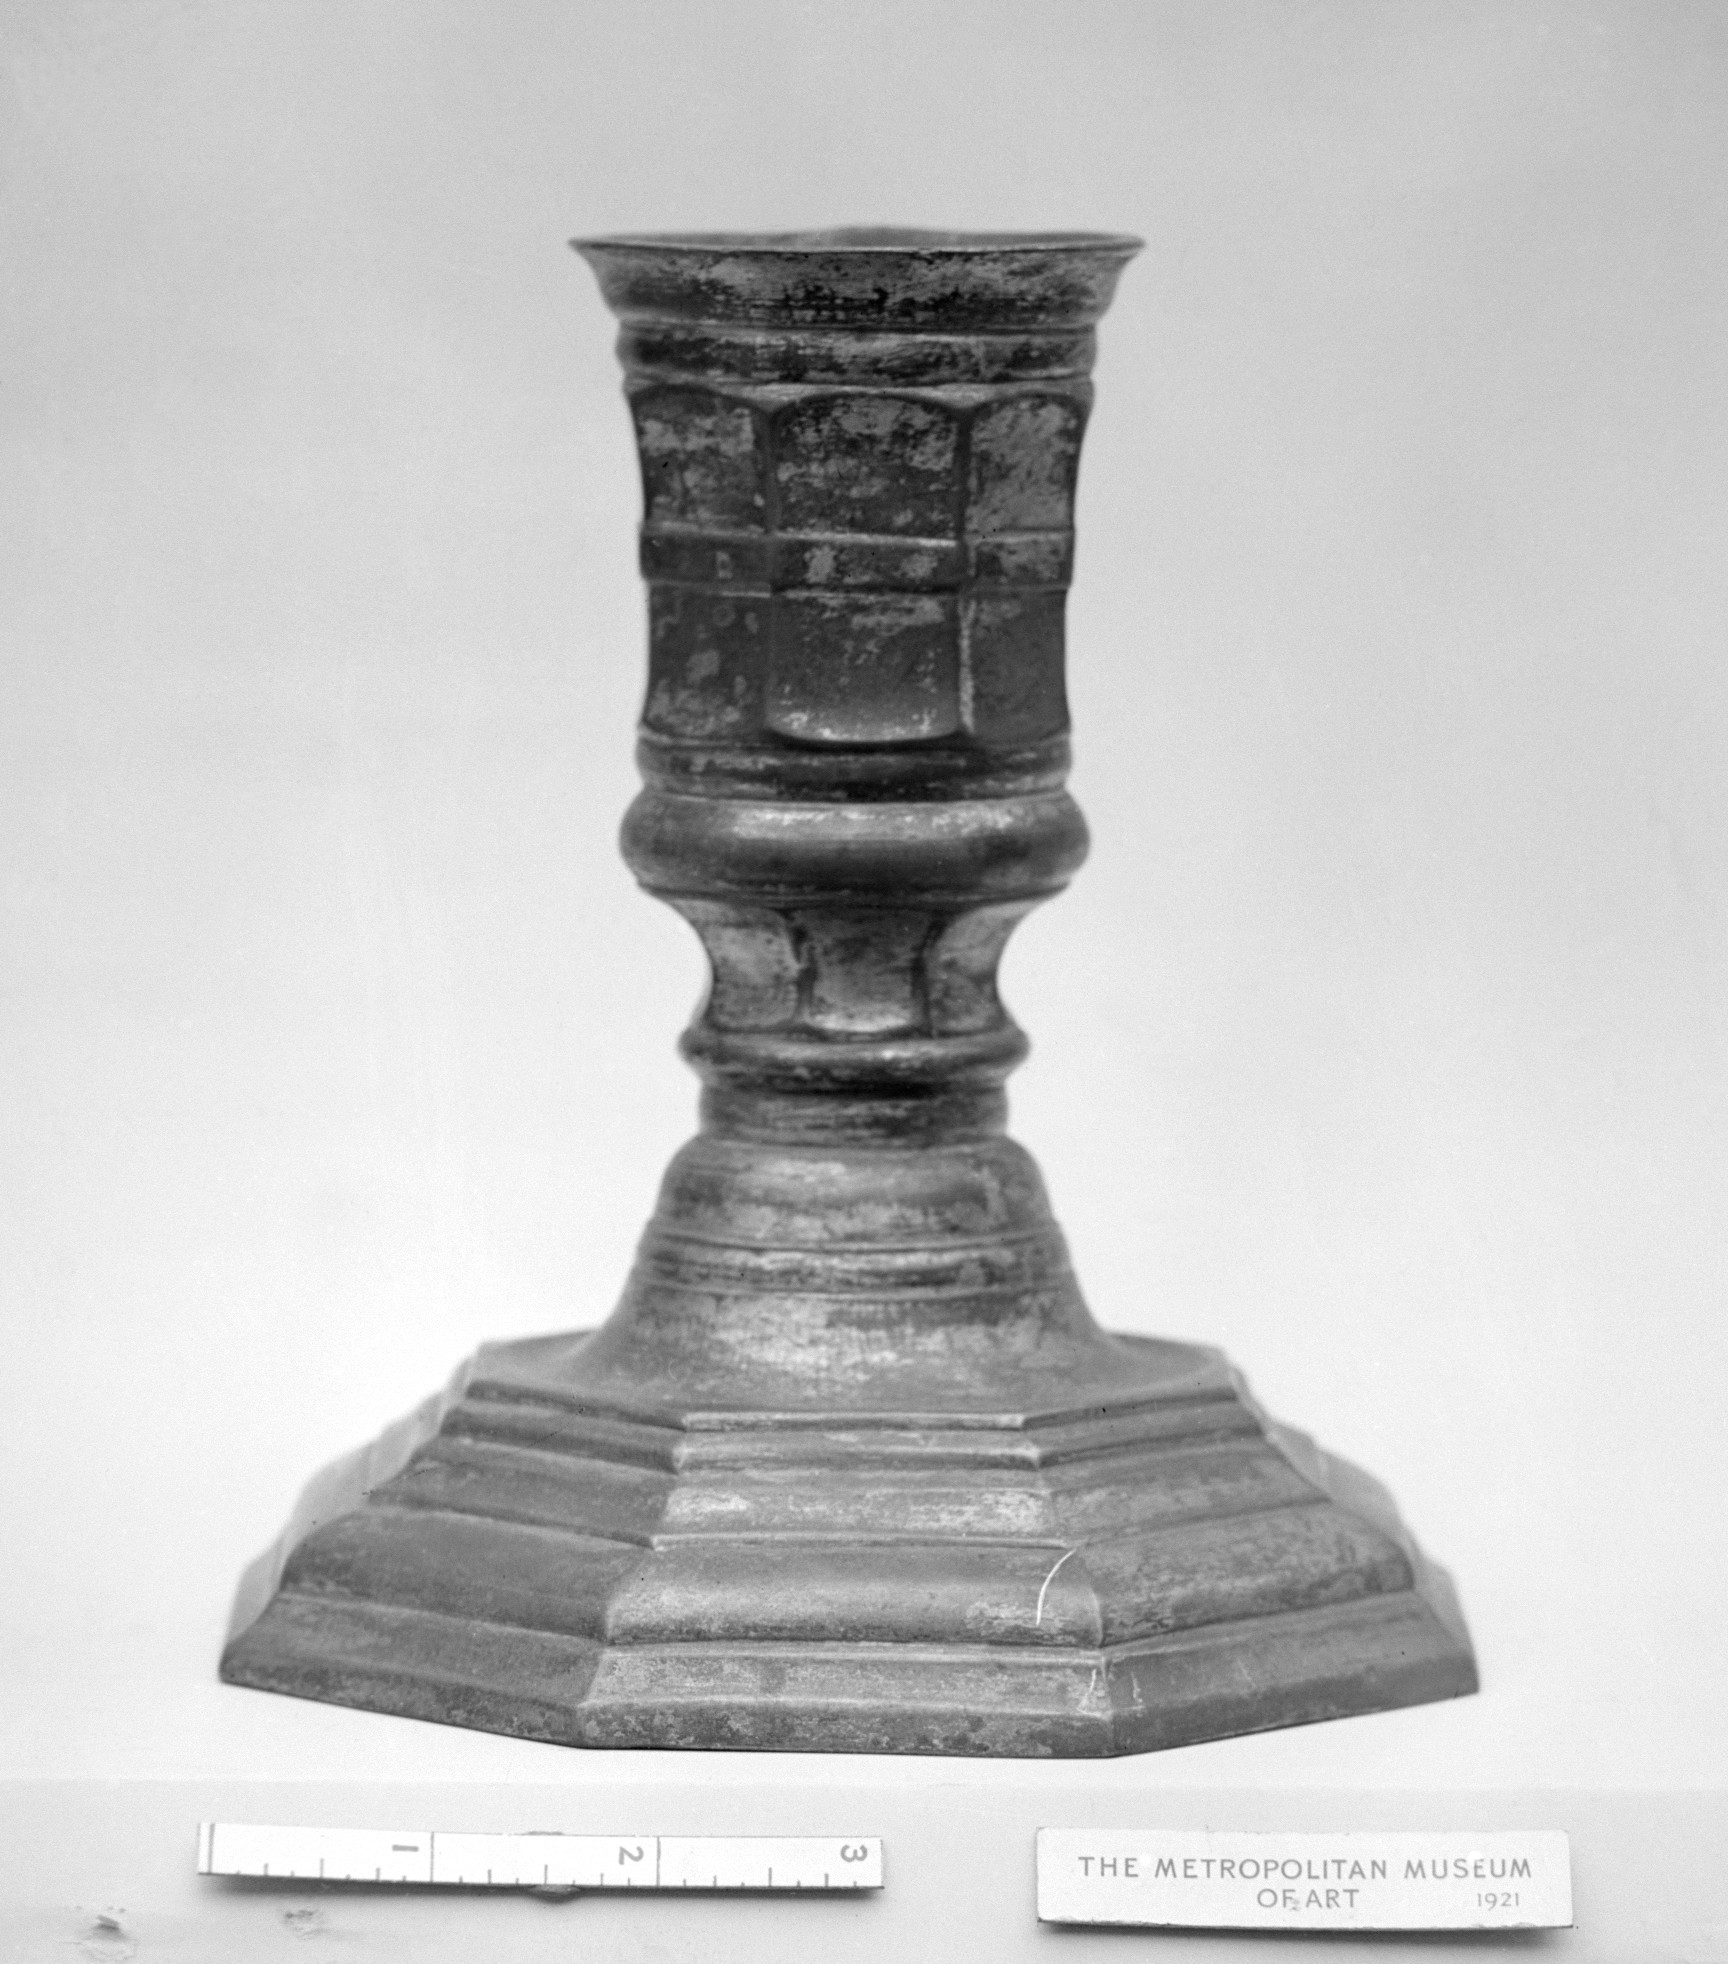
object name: candlestick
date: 1667-1700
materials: brass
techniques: silvered